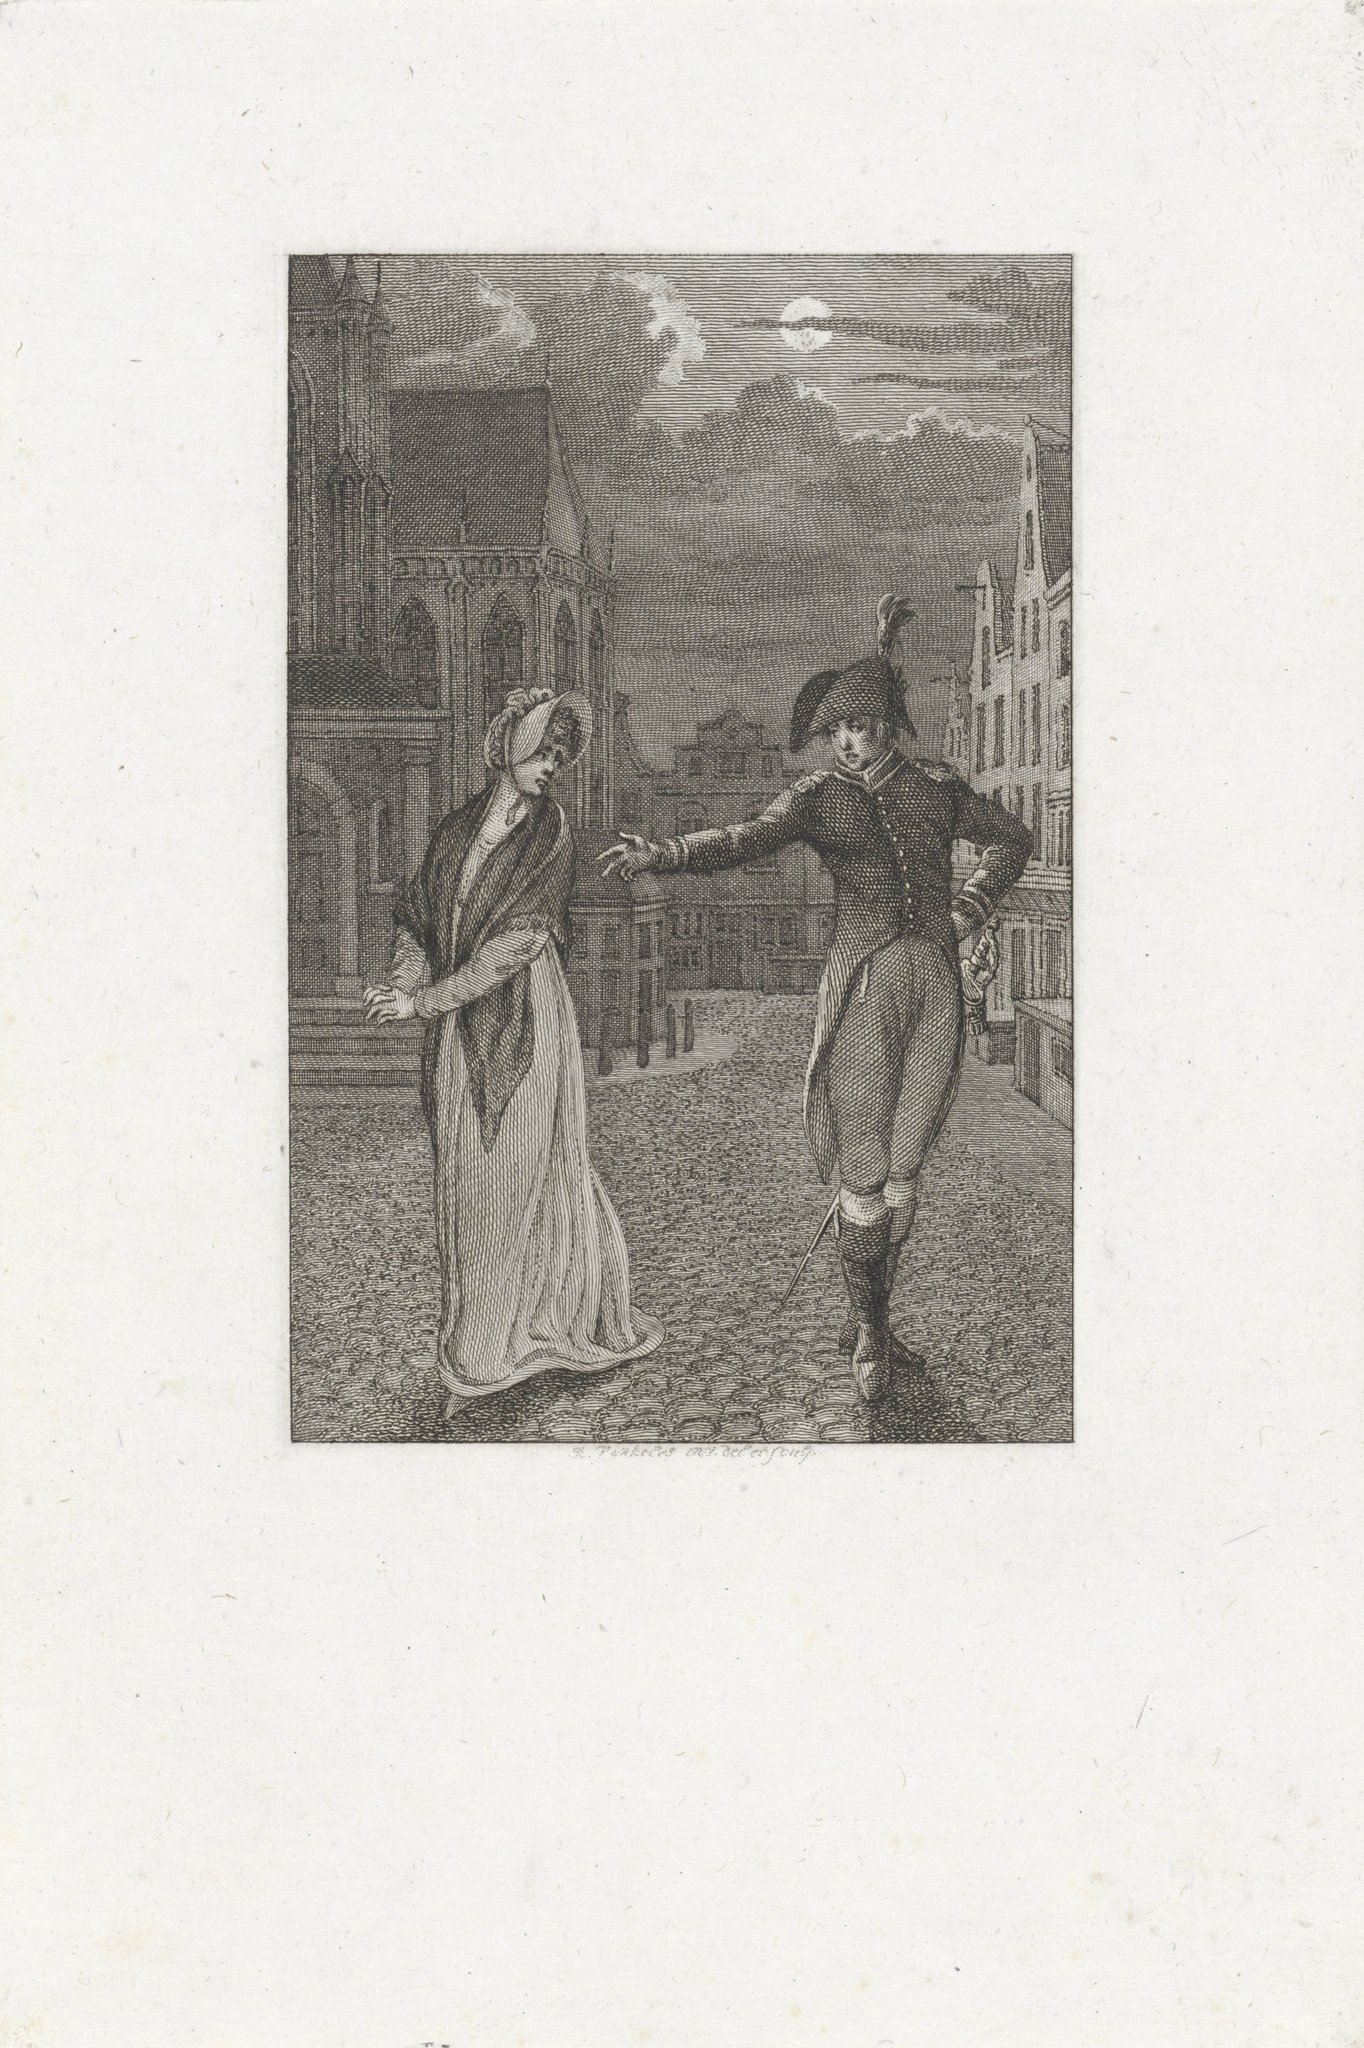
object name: print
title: Hendrik van Arkel zegt Betje vaarwel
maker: reinier vinkeles (i)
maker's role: draughtsman, print maker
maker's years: 1741-1816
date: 1804-1805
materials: paper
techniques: engraving, etching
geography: amsterdam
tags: reaching for something, church (exterior), night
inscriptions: collector's mark: Lugt 240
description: Proefdruk van illustratie die ook gebruikt is in: Loosjes, Adriaan Pietersz. Zedelijke Verhaalen. Haarlem: Adriaan Loosjes, 1804-1805. Tweede druk Haarlem: Adriaan Loosjes, 1815.